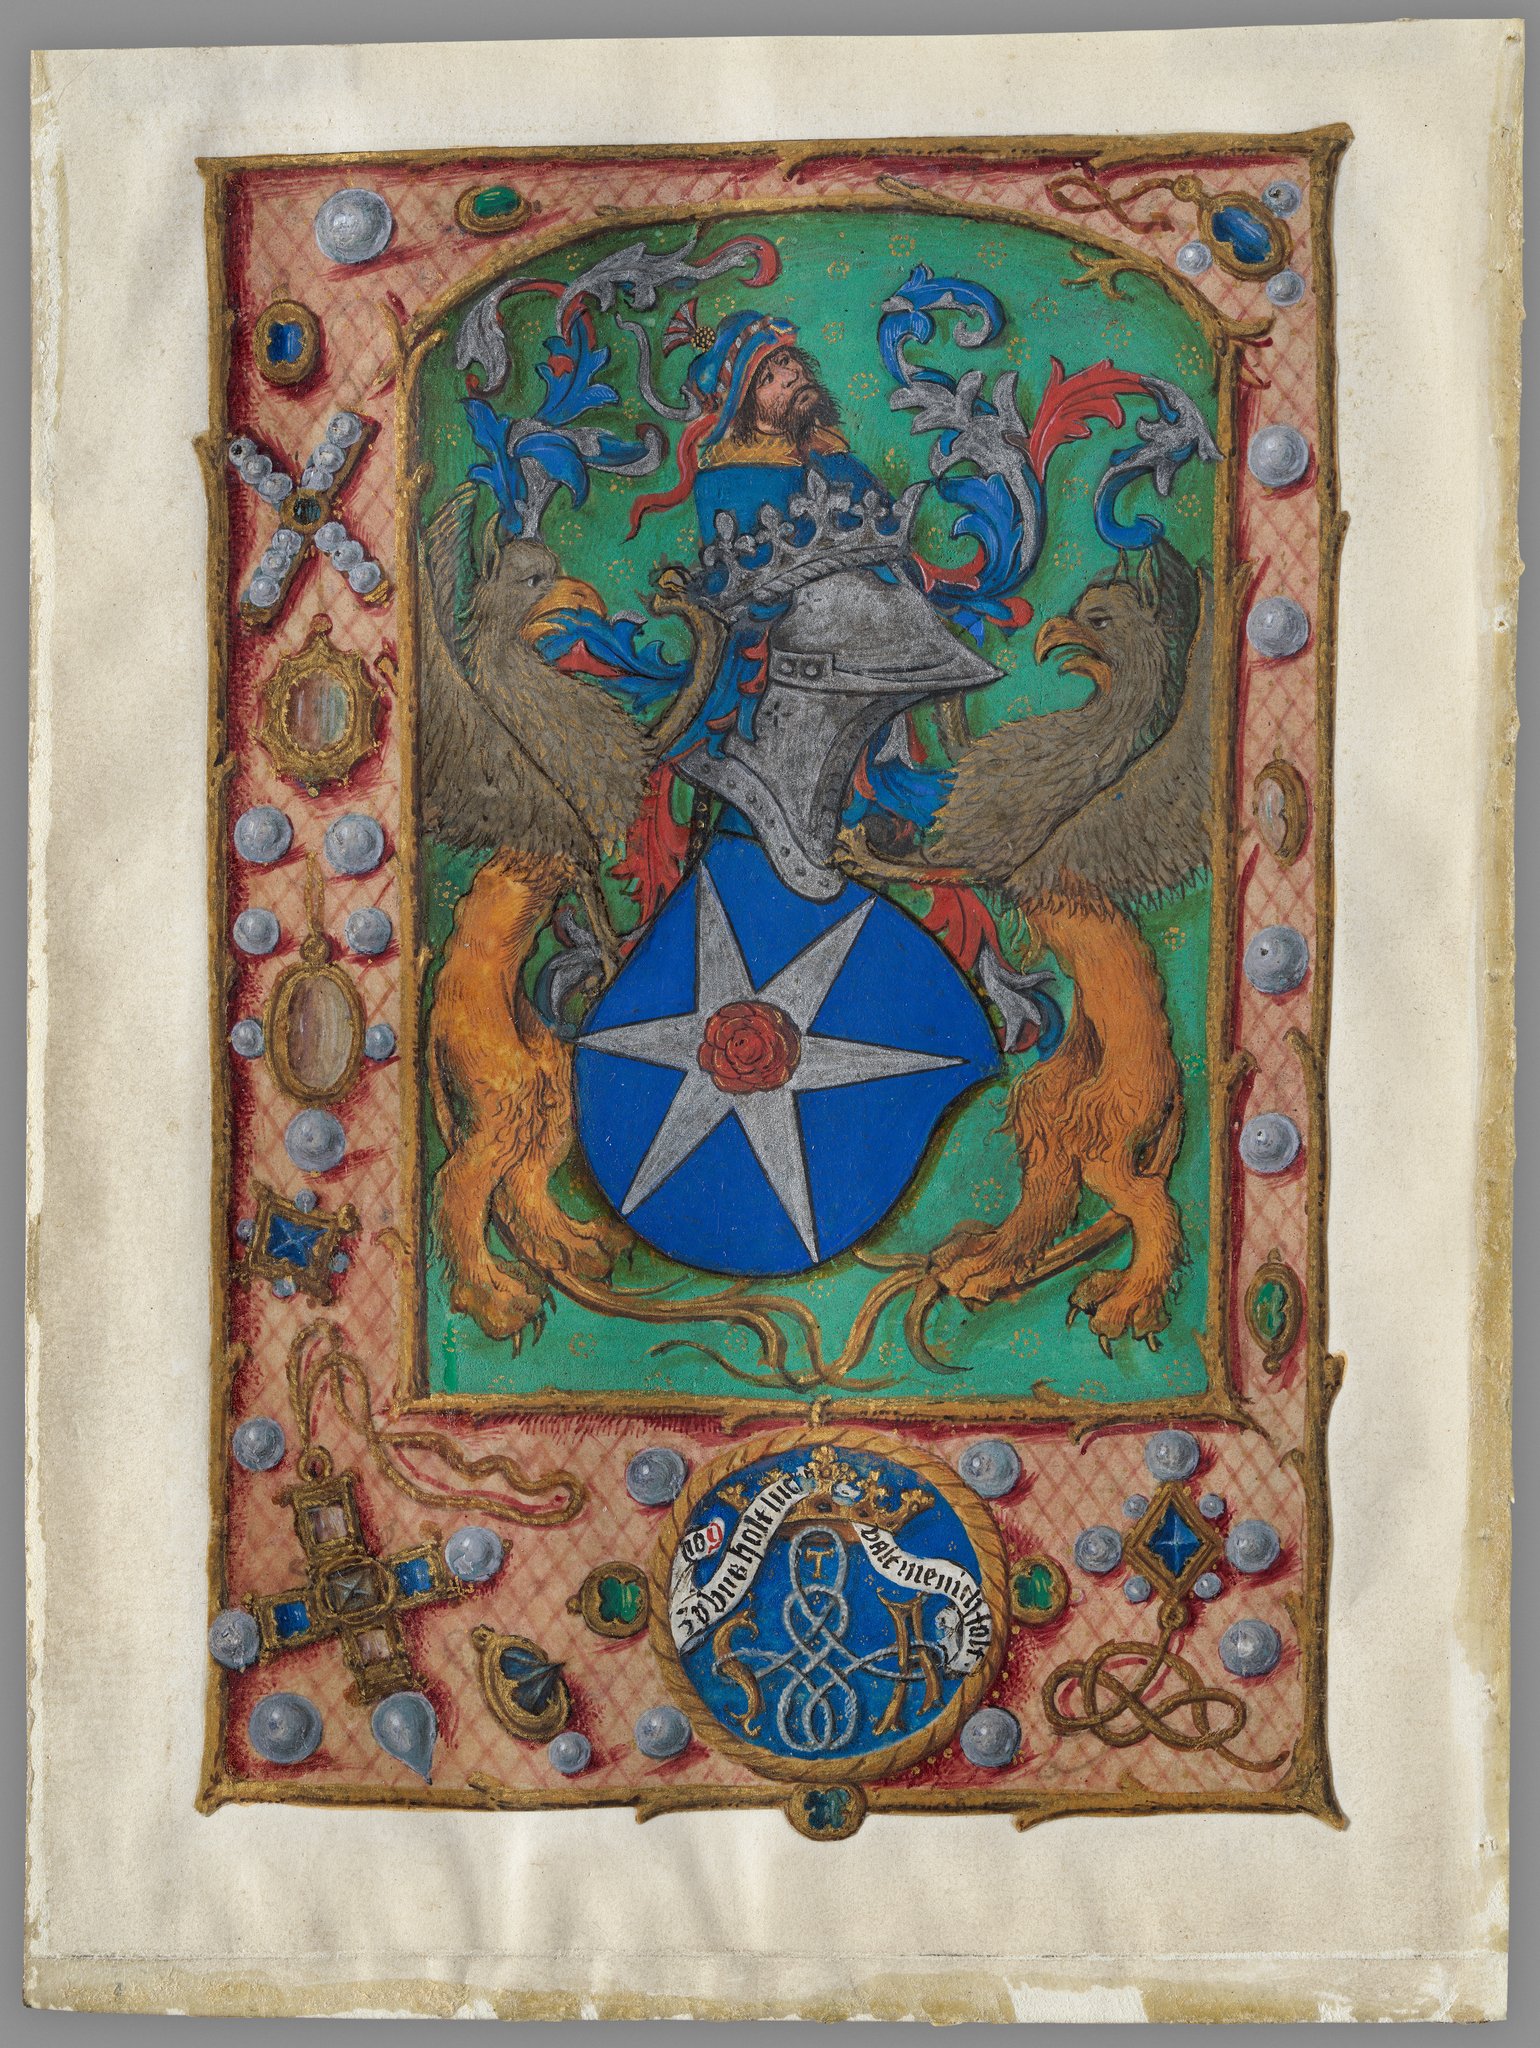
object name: book of hour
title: Manuscript Leaf with Coat of Arms, from a Book of Hours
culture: dutch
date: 1500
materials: gold, ink, parchment, shell, paint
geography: netherlands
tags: men,griffins,coat of arms